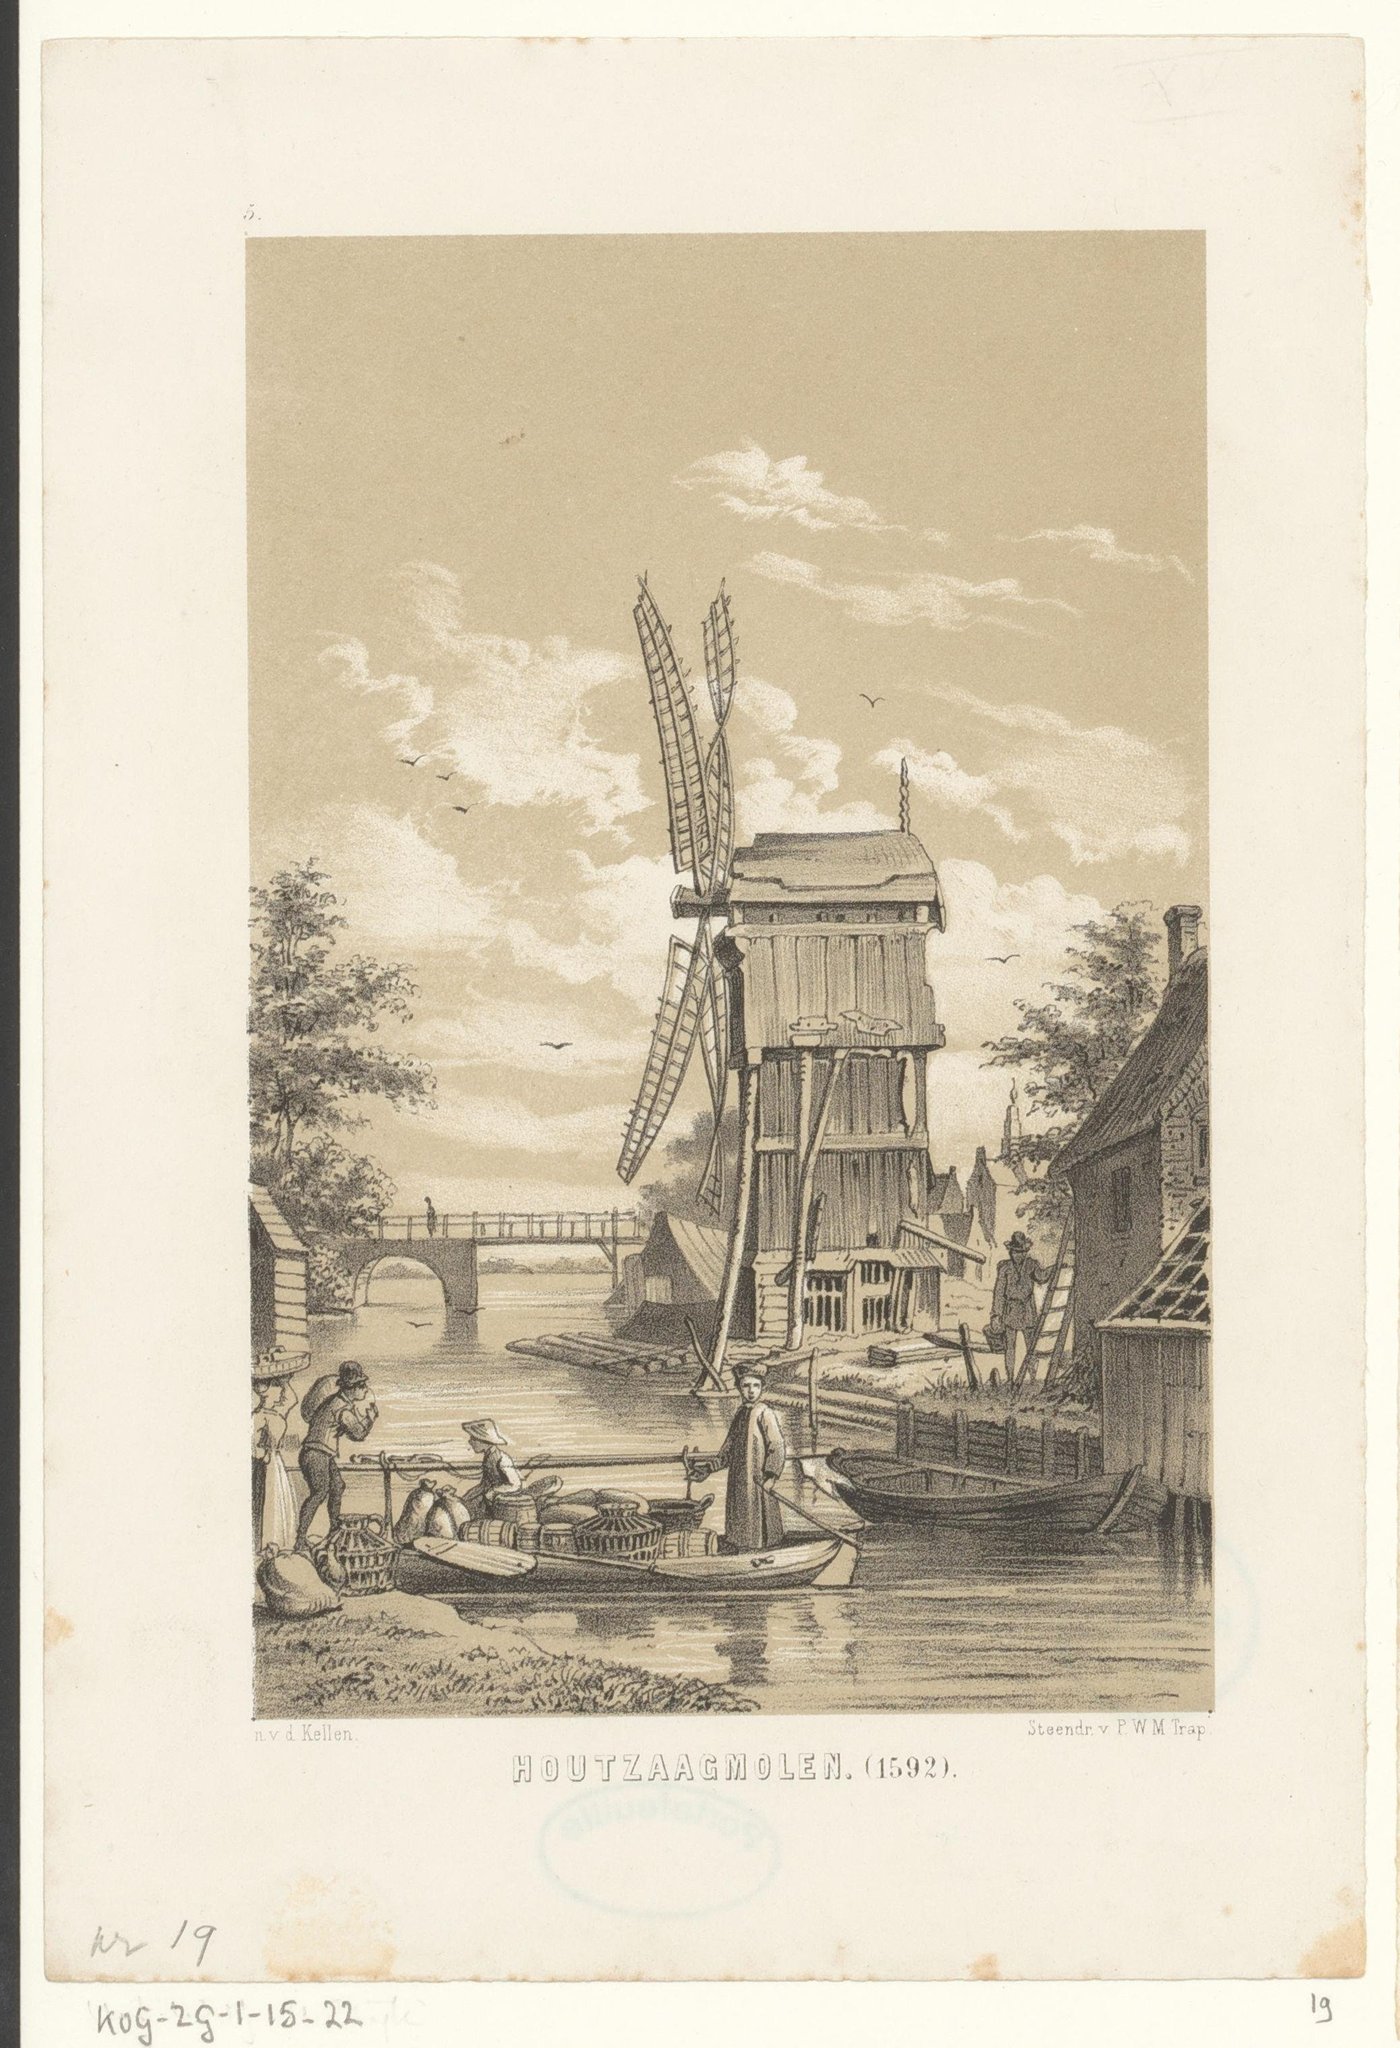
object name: print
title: Houtzaagmolen aan het water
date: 1873-1875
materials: paper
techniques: tone lithography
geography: leiden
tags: crossing a river, saw-mill (works), river, bridge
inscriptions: collector's mark: Lugt 1641, stamp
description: Prent waarschijnlijk uit: Hofdijk, W.J. Ons voorgeslacht in zijn dagelyksch leven geschilderd. Tweede druk. Leiden: P. van Santen, ca. 1875.